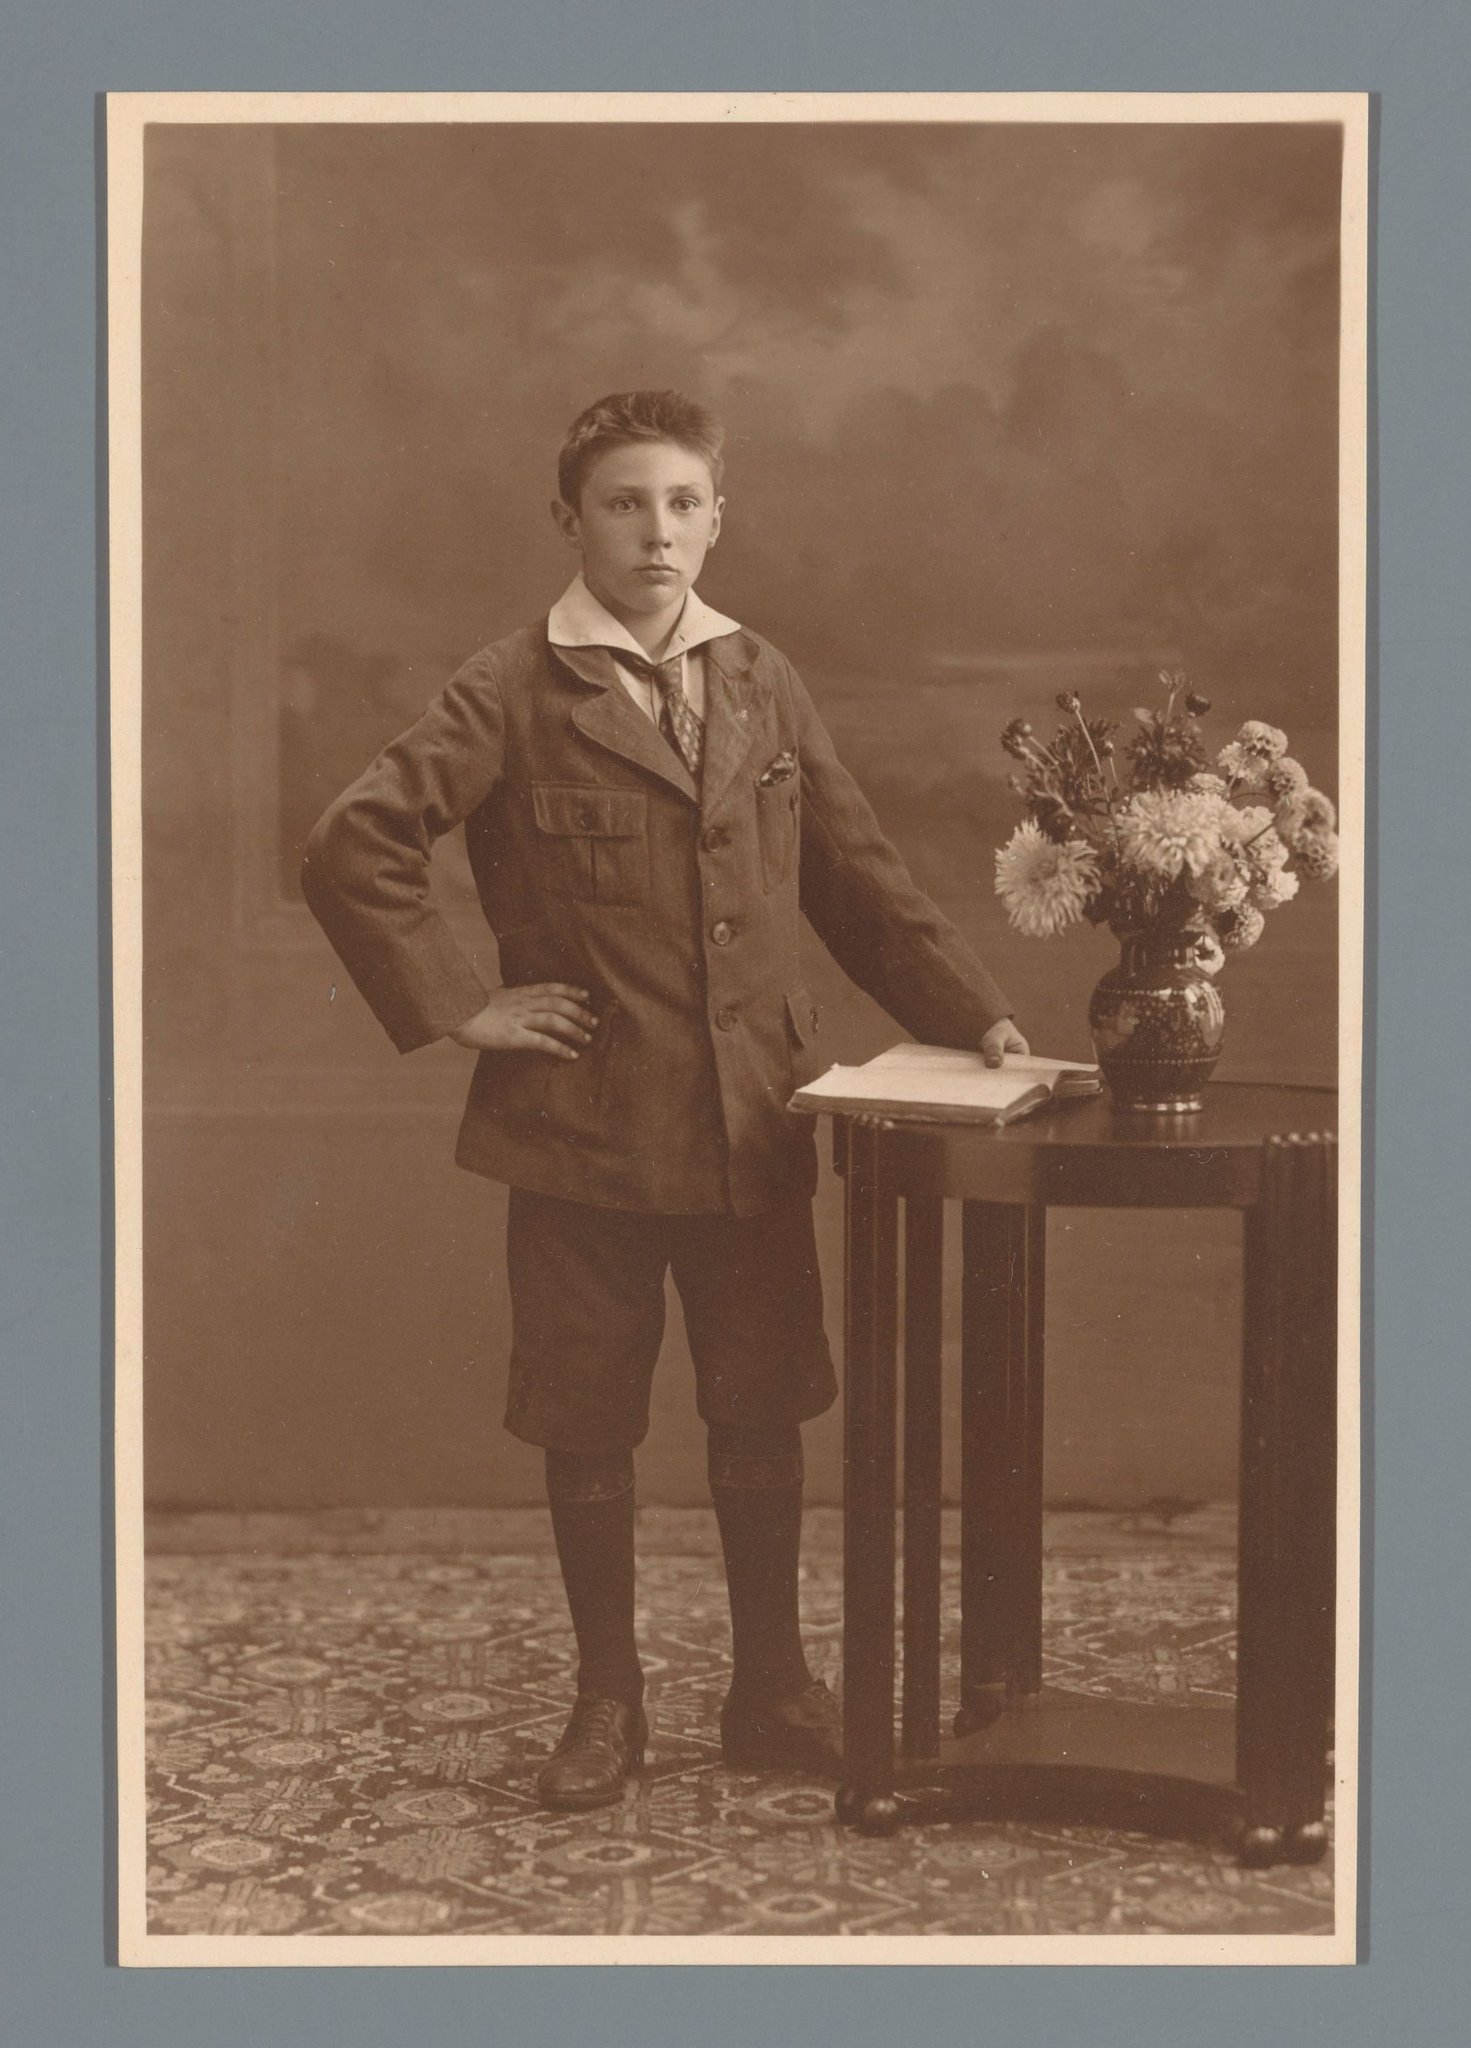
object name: photograph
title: Studioportret van een onbekende jongen naast een tafel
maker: machiel hendricus laddé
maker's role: fotograaf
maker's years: 1866-1932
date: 1907-1920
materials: photographic support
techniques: gelatin silver print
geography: amsterdam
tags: cut flowers; nosegay, bunch of flowers, boy (child between toddler and youth), table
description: RP-F-F20756 t/m RP-F-F20759 zijn 4 exemplaren van dezelfde foto.